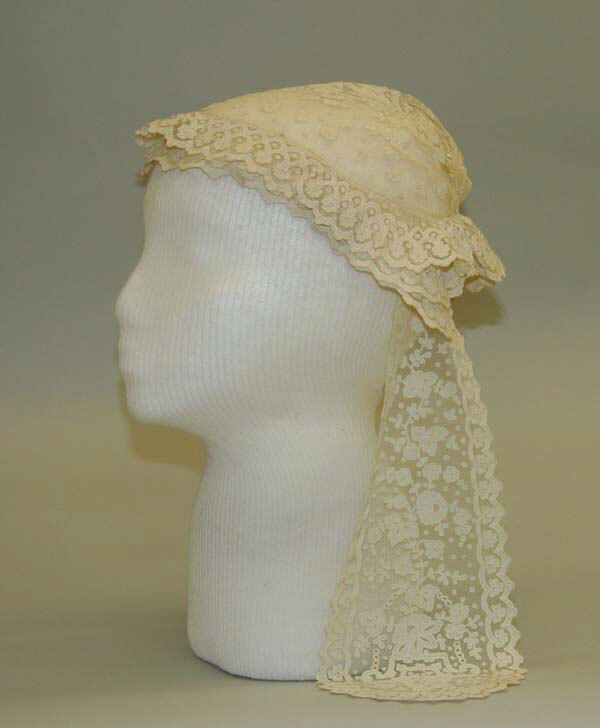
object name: cap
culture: american or european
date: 1834-1866